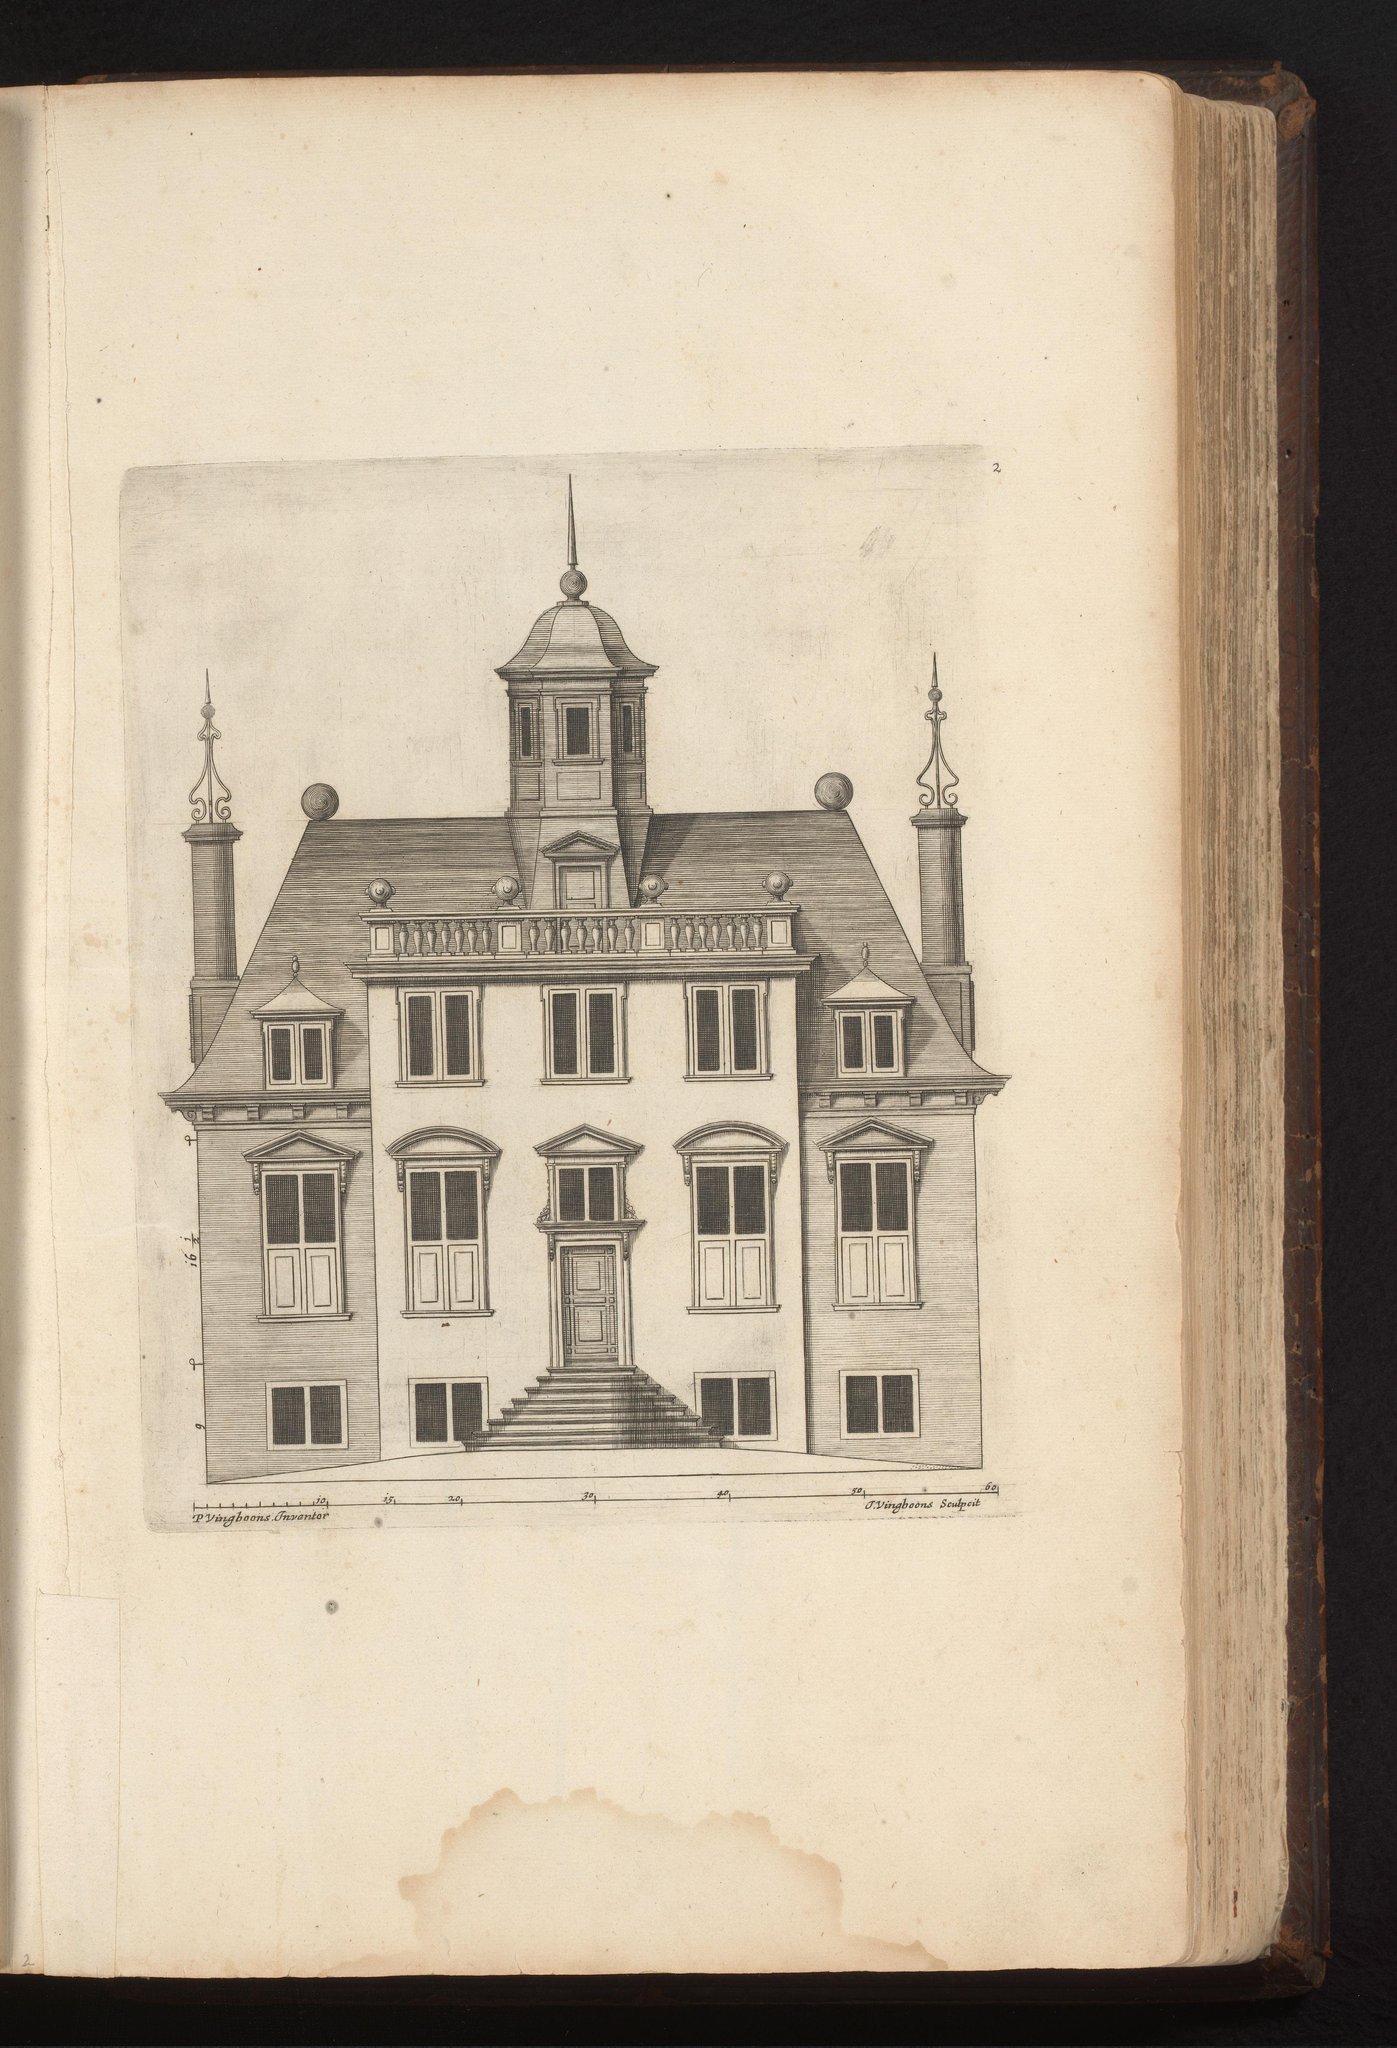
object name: print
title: Gevel van het landhuis Elsenburch te Maarsseveen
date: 1648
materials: paper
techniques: engraving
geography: amsterdam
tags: country-house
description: Prent uit: Afbeelsels der voornaemste gebouwen uyt alle die Philips Vingboons geordineert heeft. Amsterdam: Philips en Johannes Vinckboons en Johannes Willemszoon Blaeu, 1648.